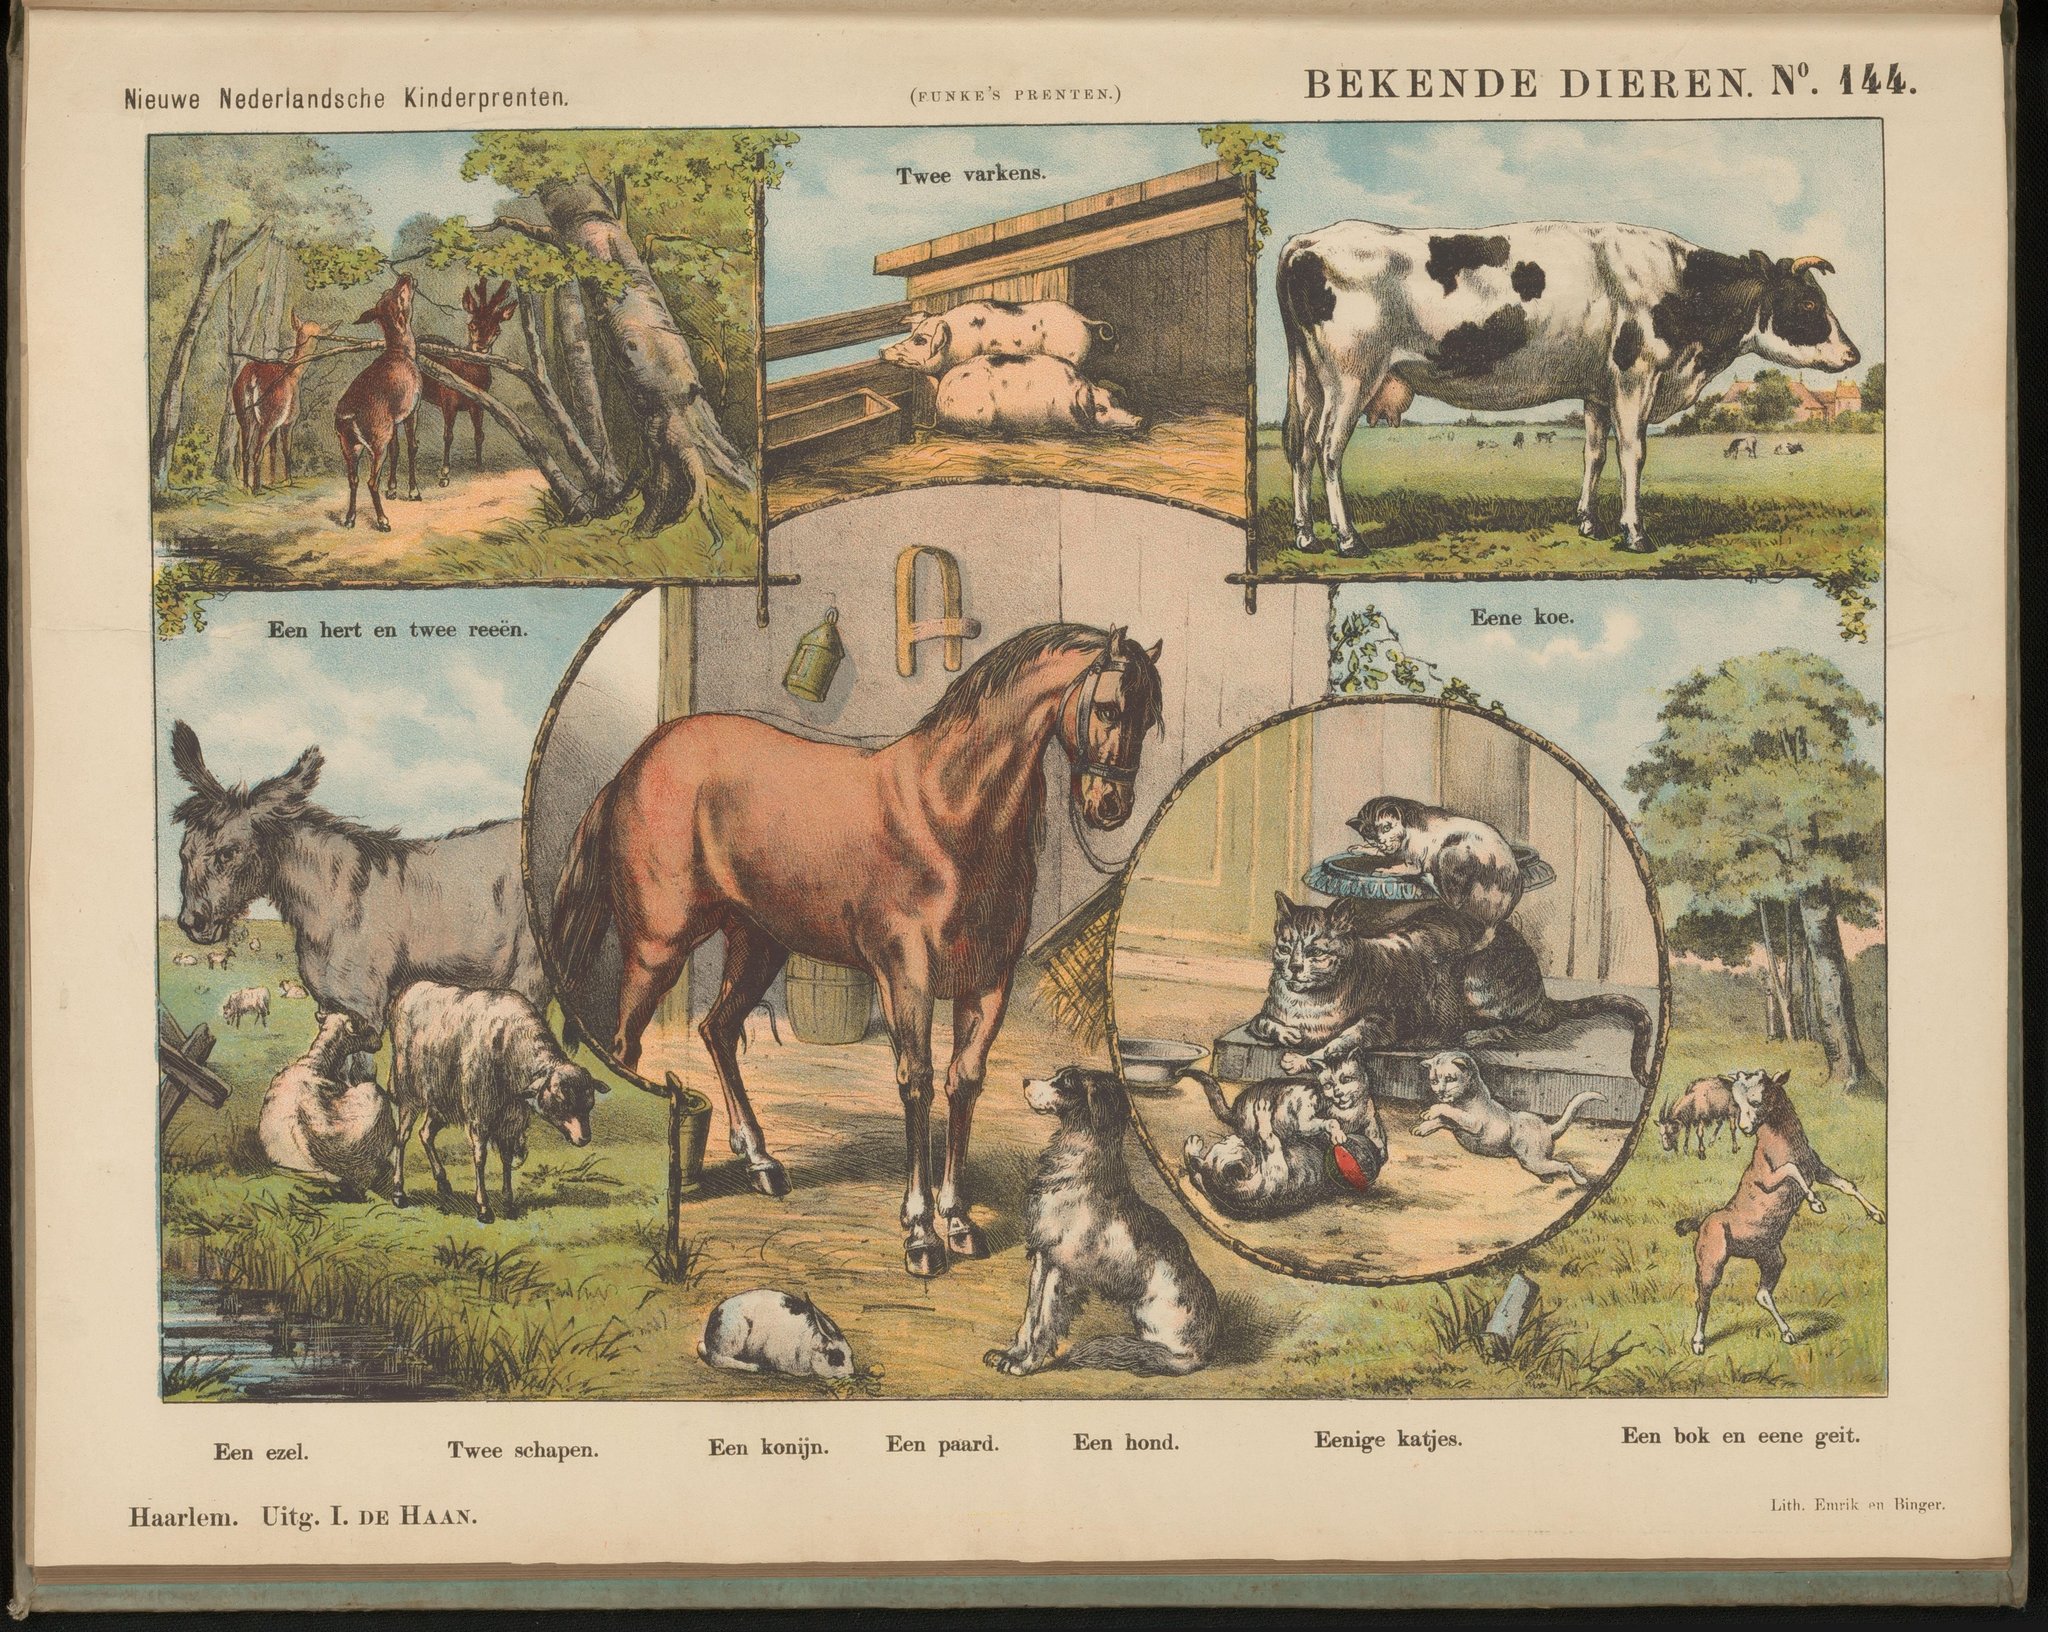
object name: popular print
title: Bekende dieren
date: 1875-1903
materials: paper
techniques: lithograph, letterpress printing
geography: haarlem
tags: cow, animals, cat, ass, donkey, horse, dog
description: Blad met 7 voorstellingen van boerderijdieren, zoals een koe, een ezel en katten. In de ondermarge onderschriften. Genummerd rechtsboven: No. 144. Onderwerpsrubrieken binnen de Atlas Zeden en Gewoonten: Zeden en gewoonten in engeren zin, Des menschen begin, midden en einde.